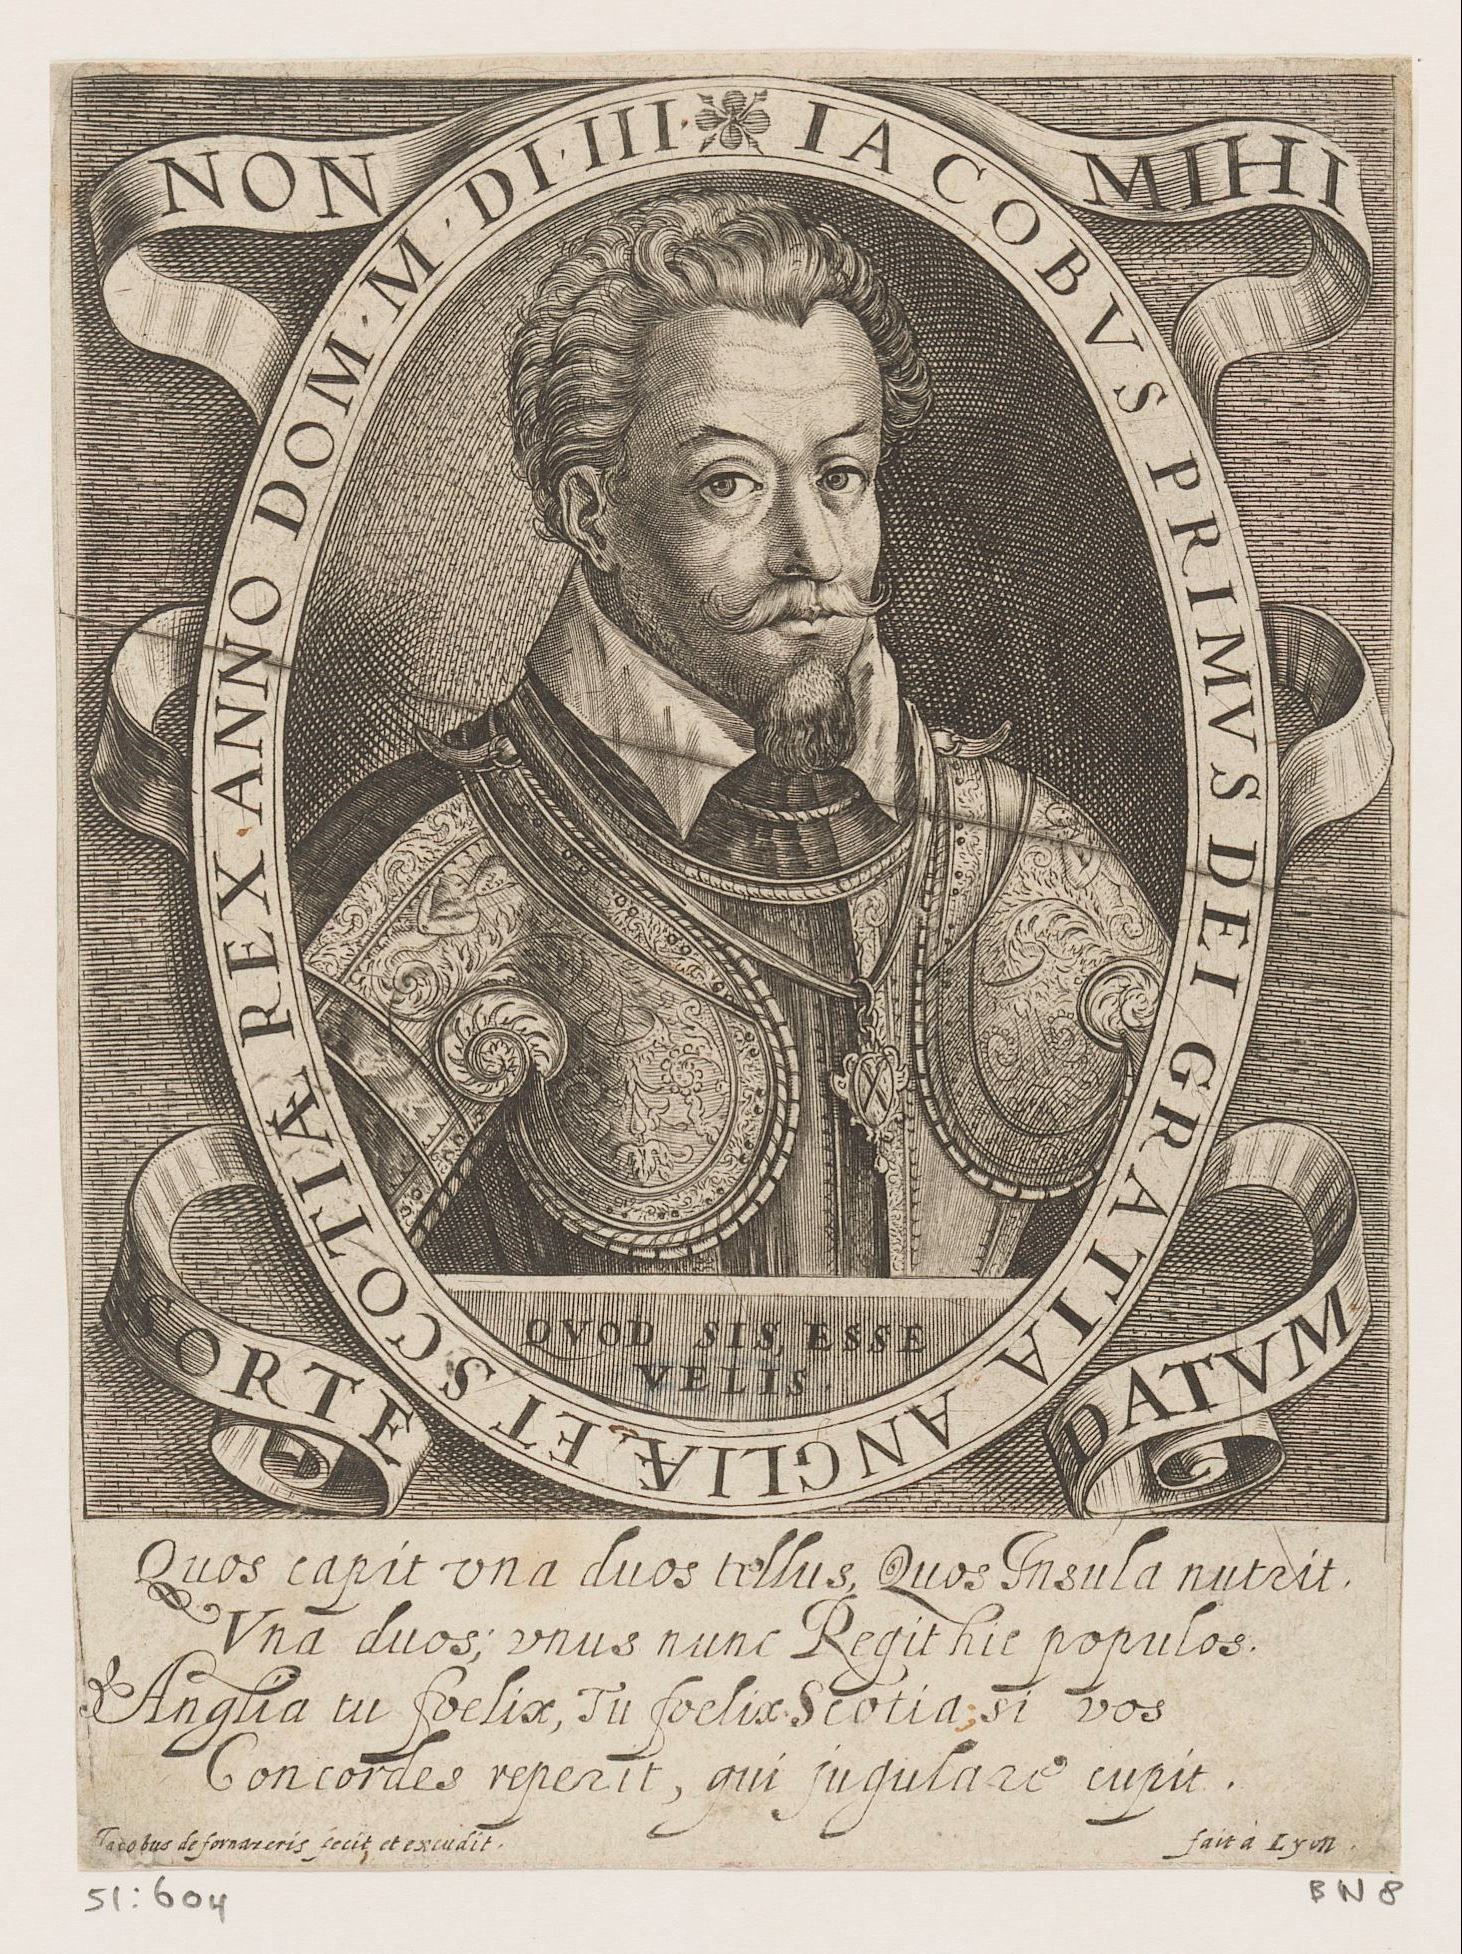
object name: print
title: Portret van koning Jacobus I van Engeland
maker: jacques de fornazeris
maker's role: draughtsman, print maker, publisher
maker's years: 1585-1619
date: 1603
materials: paper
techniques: engraving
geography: lyon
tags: jacobus i (koning van engeland), historical persons, king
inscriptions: collector's mark: Lugt 2228